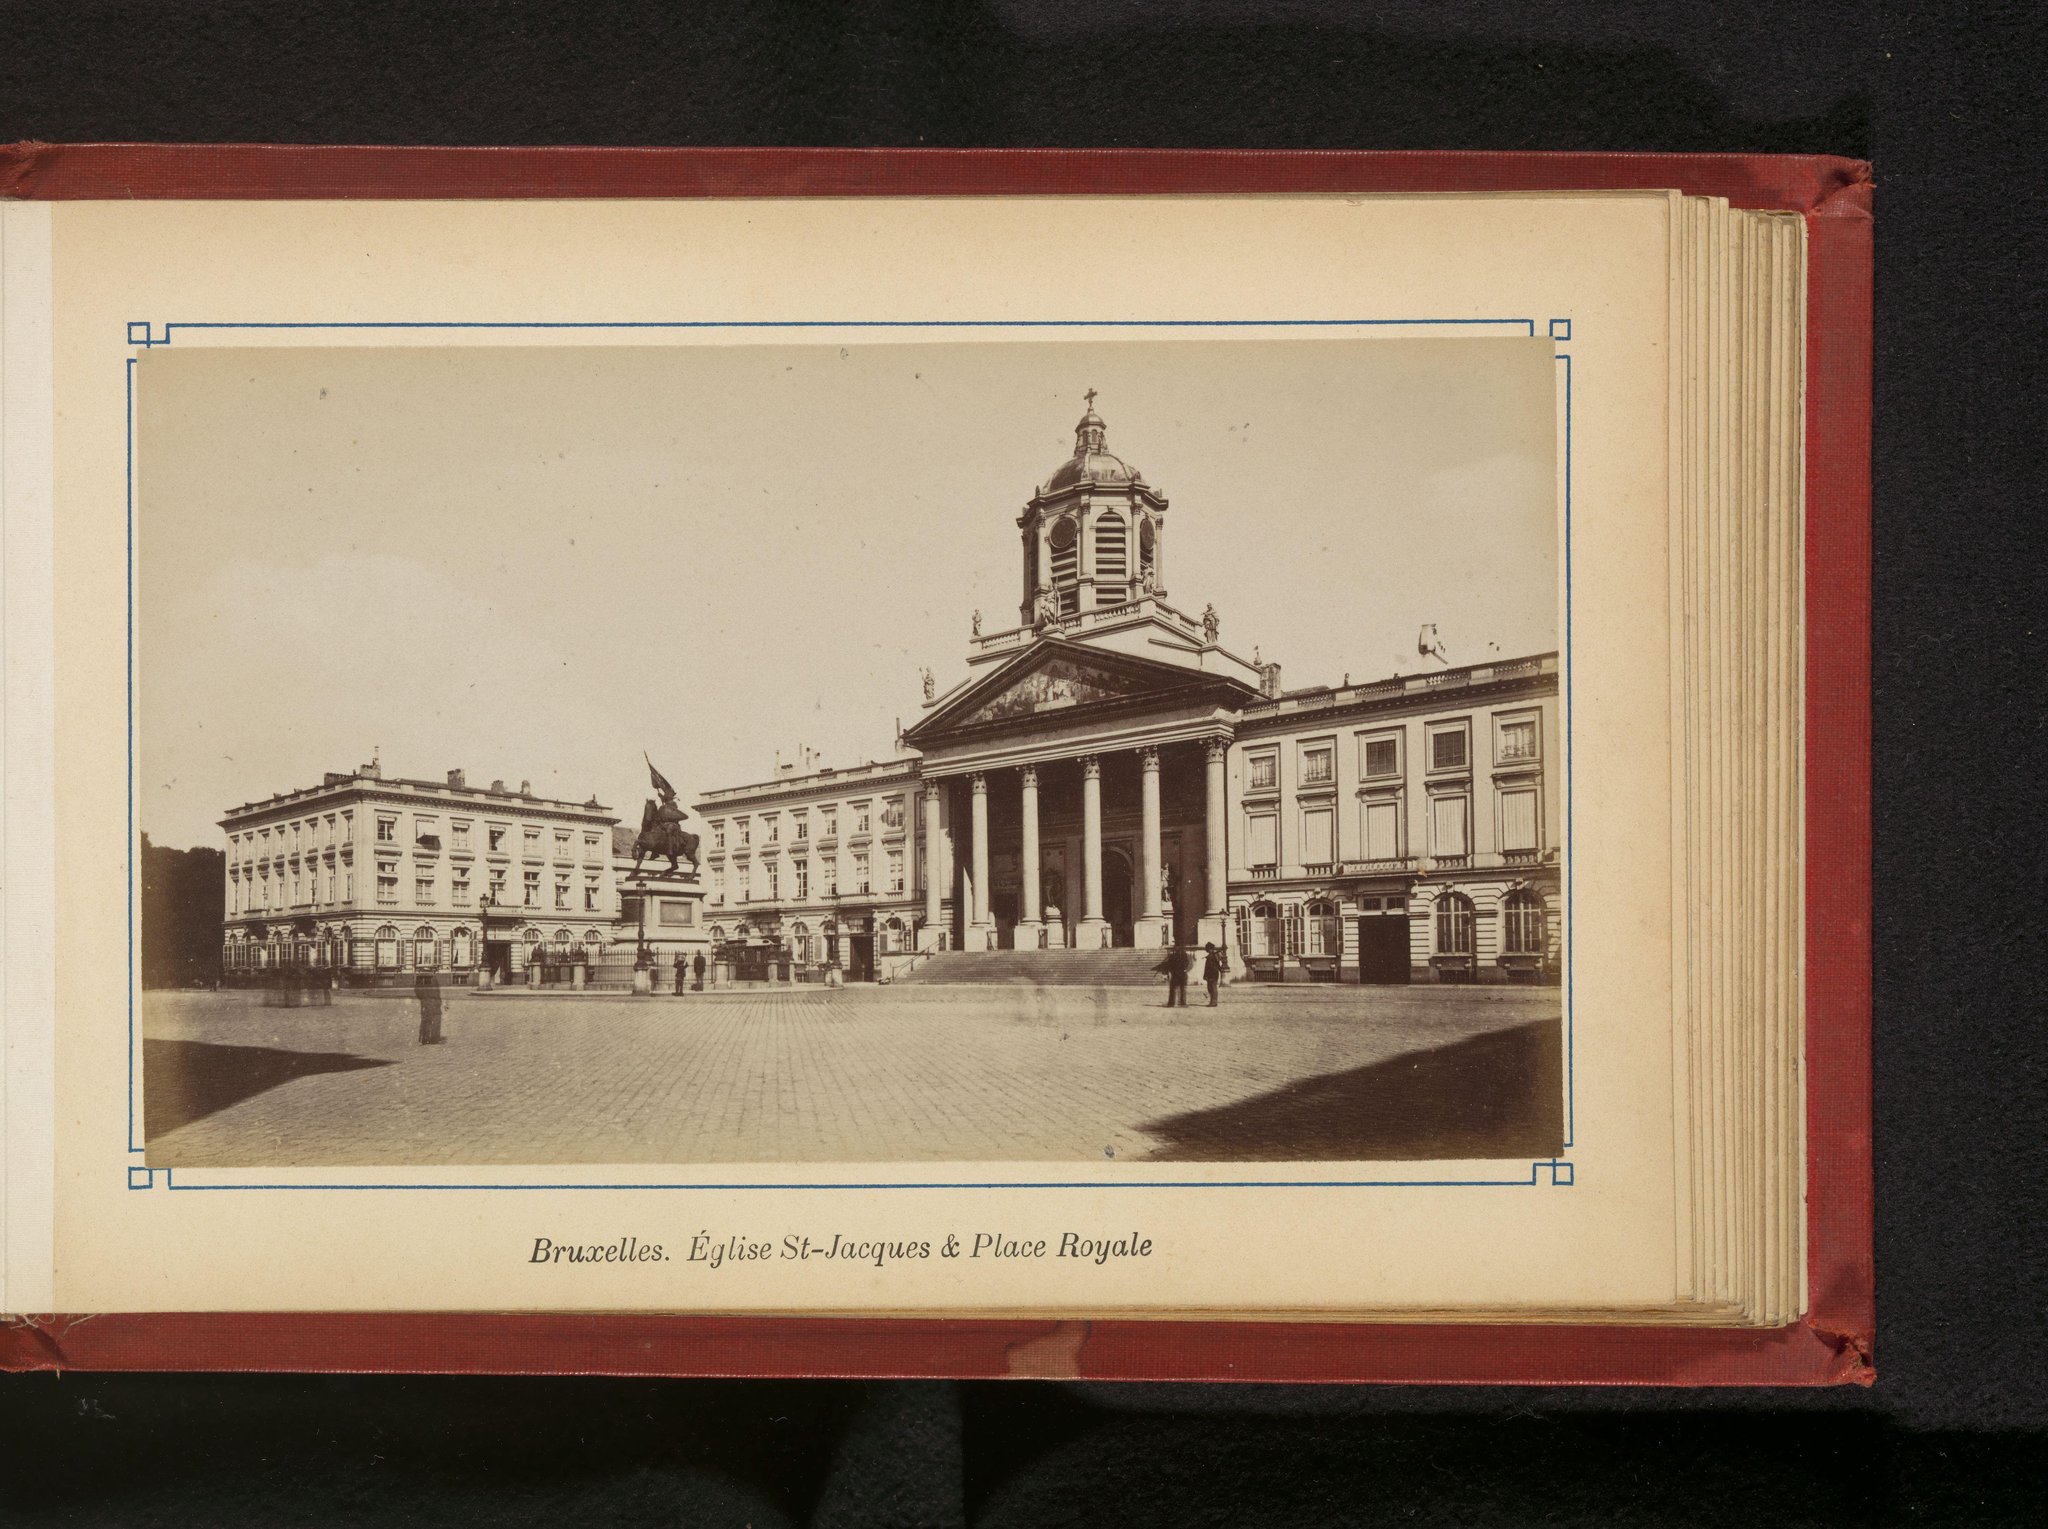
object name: page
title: Gezicht op het Koningsplein en de Sint-Jacob-op-Koudenbergkerk te Brussel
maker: Anonymous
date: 1875-1880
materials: photographic support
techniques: albumen print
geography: koningsplein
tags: church (exterior), square, place, circus, etc. (+ city(-scape) with figures, staffage)